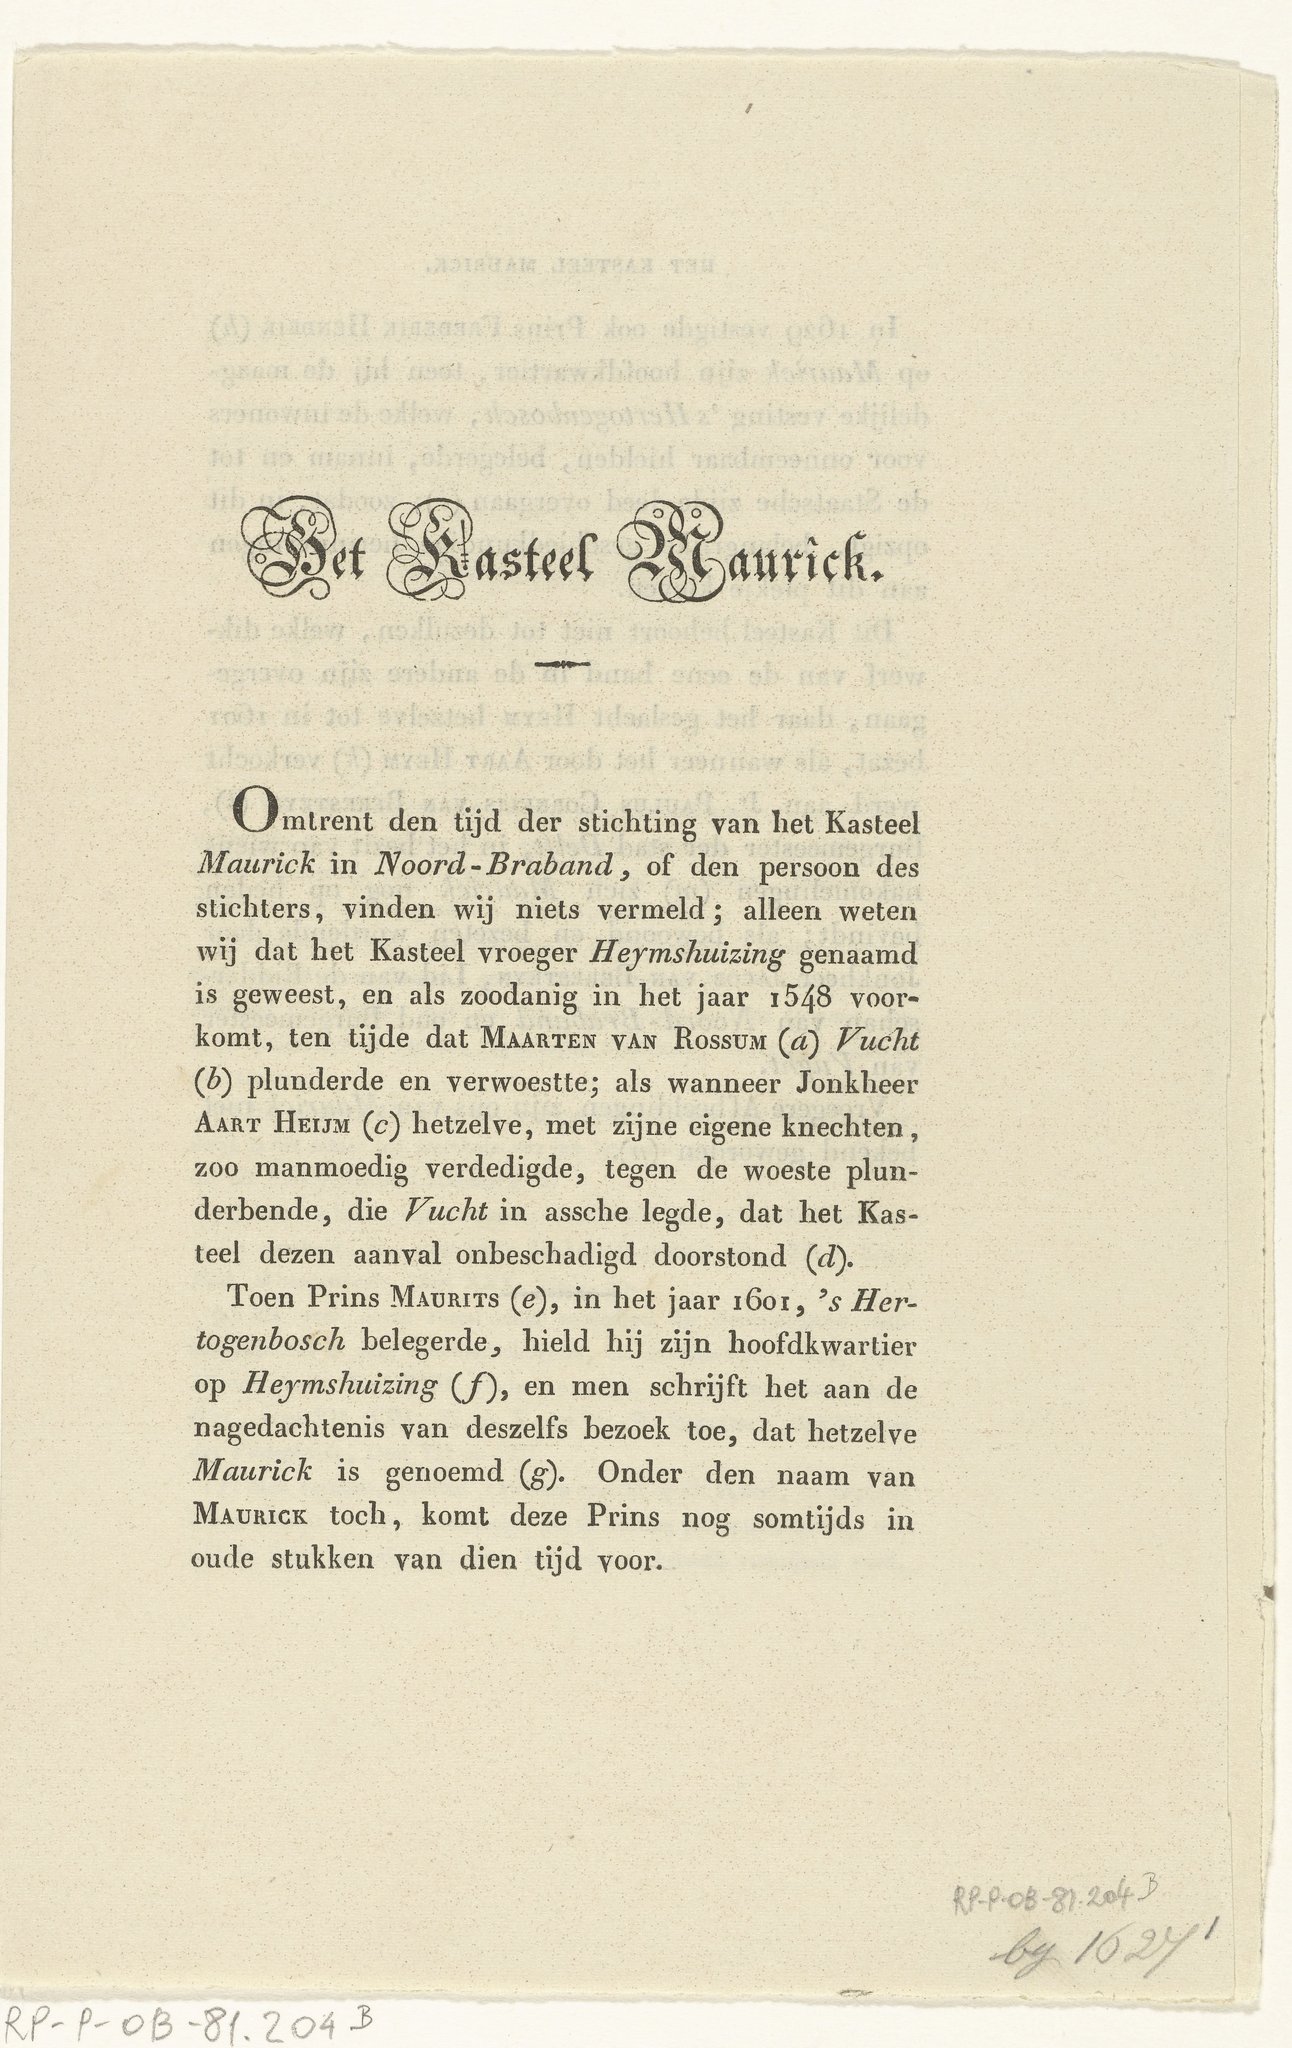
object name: text sheet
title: Tekst over Kasteel Maurick, gebruikt ter inlegering tijdens het beleg van Den Bosch, 1629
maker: christiaan august vieweg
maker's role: publisher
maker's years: 1799-1873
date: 1837-1846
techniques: printmaking, letterpress printing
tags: delft, the hague, frederick henry (prince of orange)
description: Tekst afkomstig uit: C.P.E. Robidé van der Aa, Oud-Nederland in de uit vroegere dagen, overgeblevene burgen en kasteelen, geschetst en afgebeeld, Vieweg, Nijmegen 1841-1846.